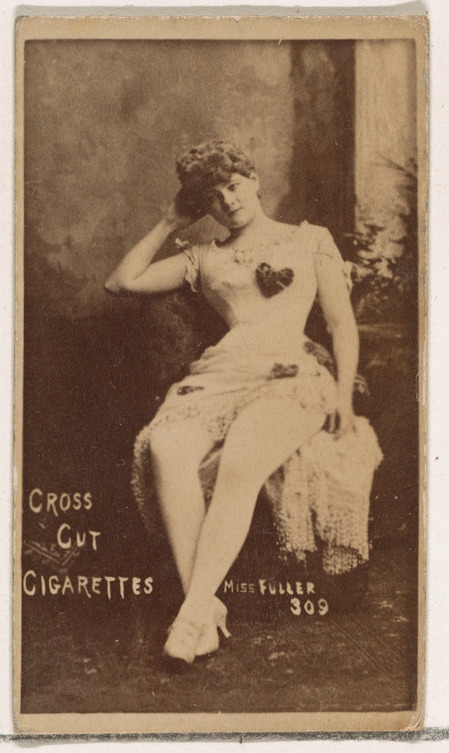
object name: print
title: Card Number 309, Miss Fuller, from the Actors and Actresses series (N145-1) issued by Duke Sons & Co. to promote Cross Cut Cigarettes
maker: w. duke, sons & co.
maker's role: publisher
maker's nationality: american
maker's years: 1870-1920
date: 1880-1889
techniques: albumen silver print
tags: portraits,women,actresses